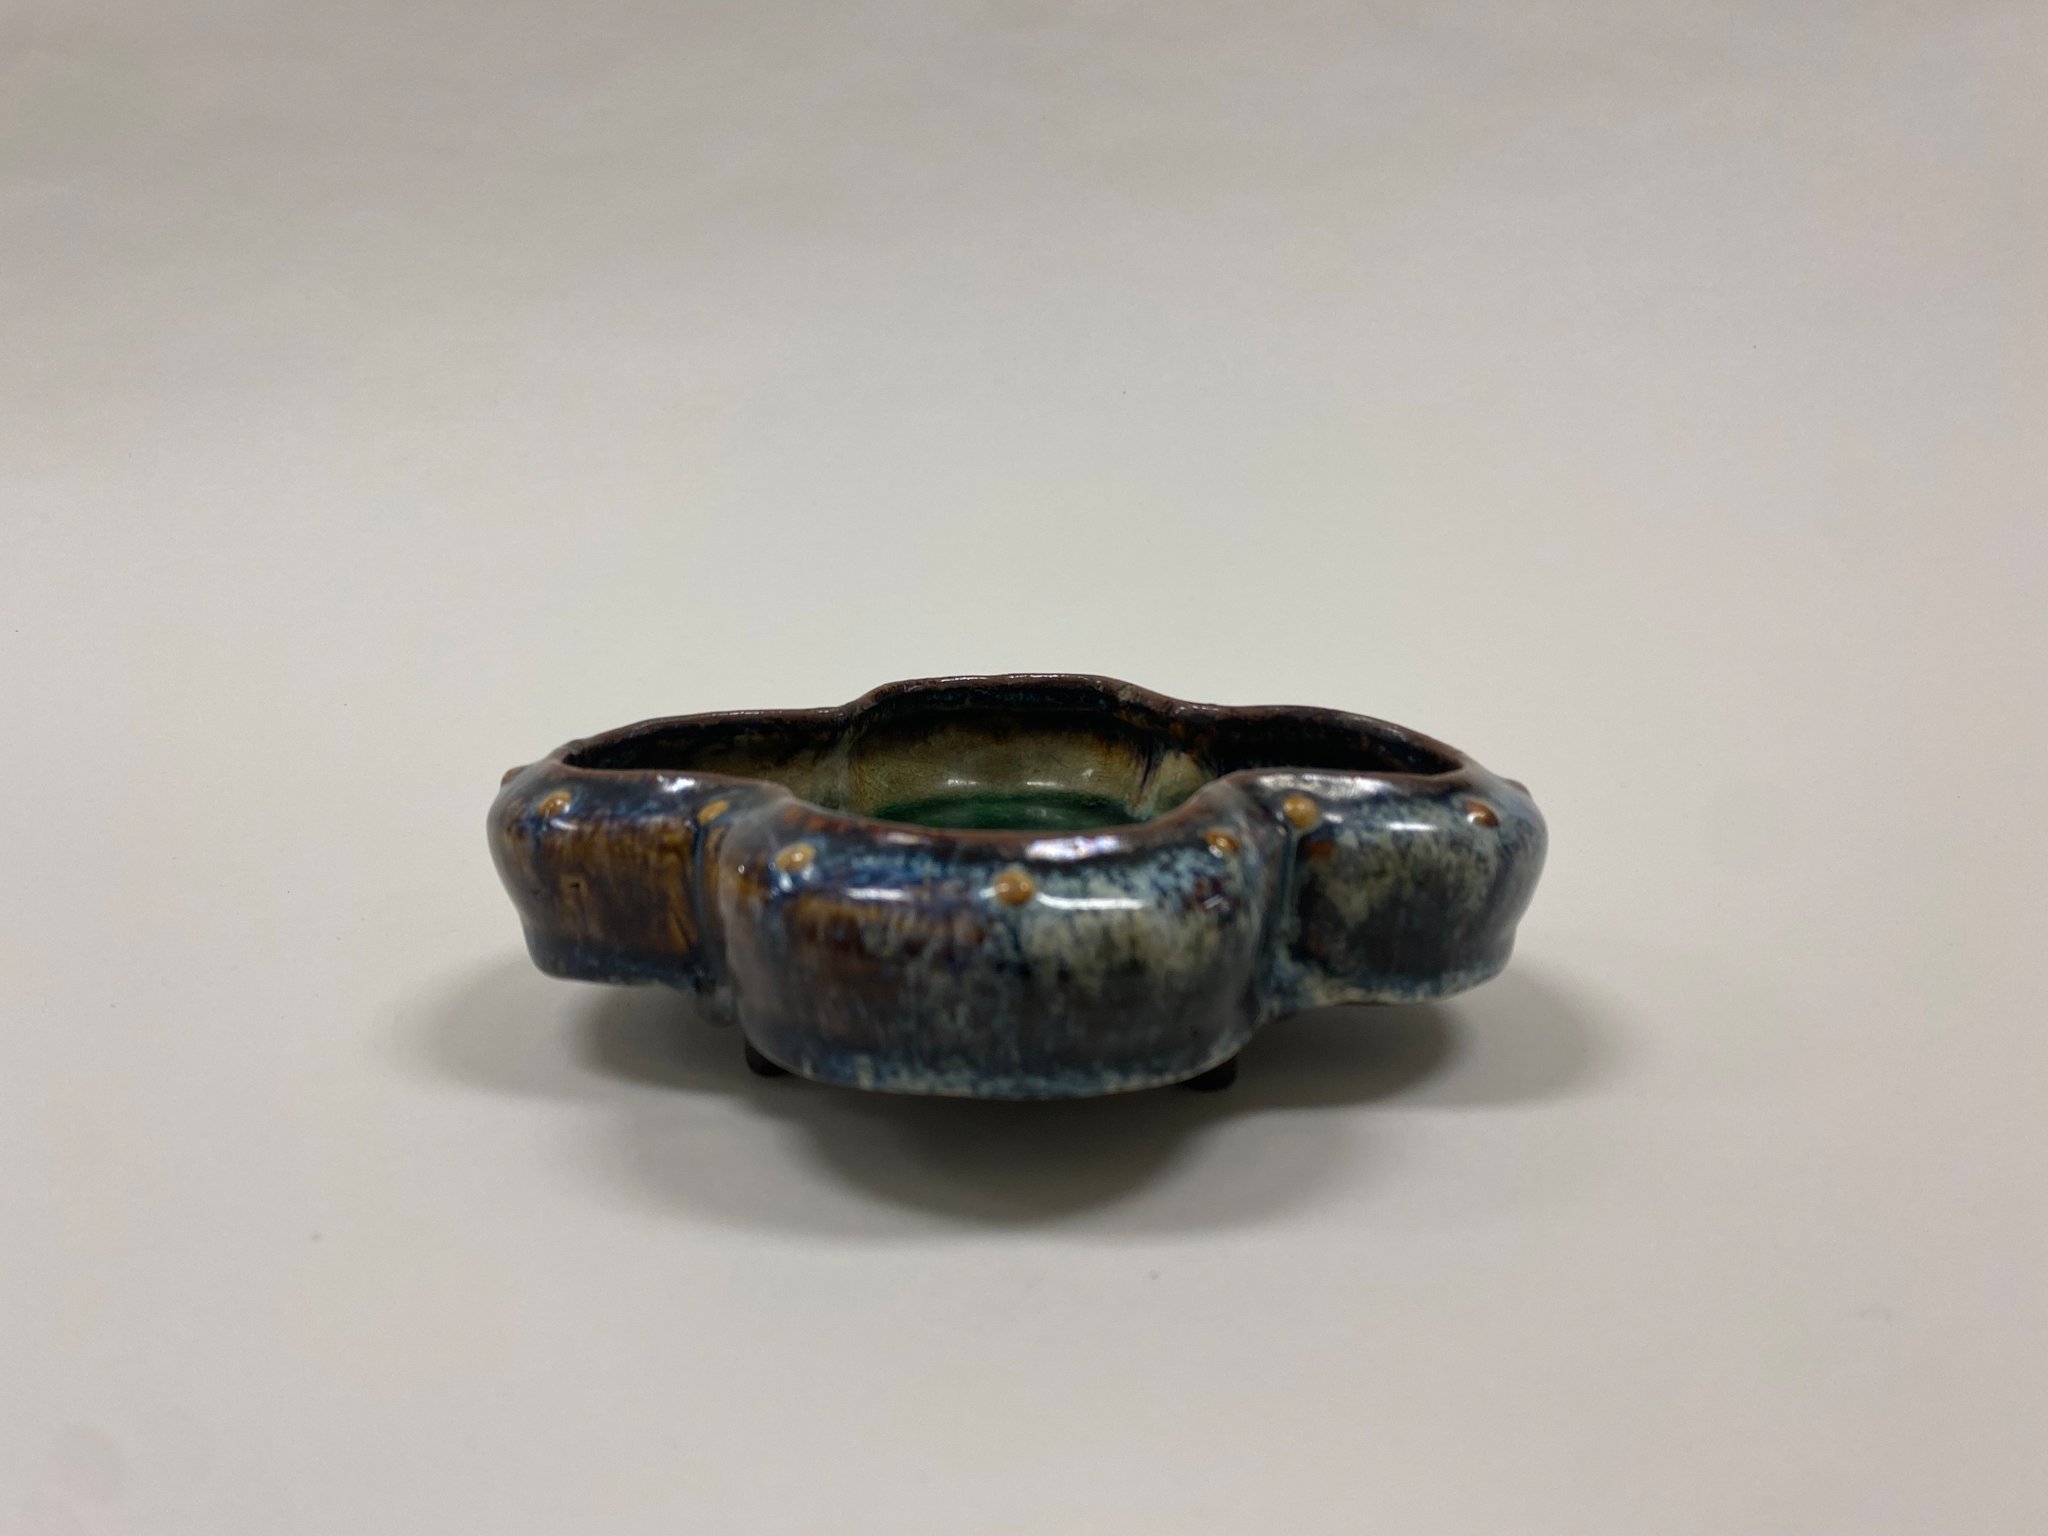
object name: planter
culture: chinese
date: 1801-1900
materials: glaze, stoneware